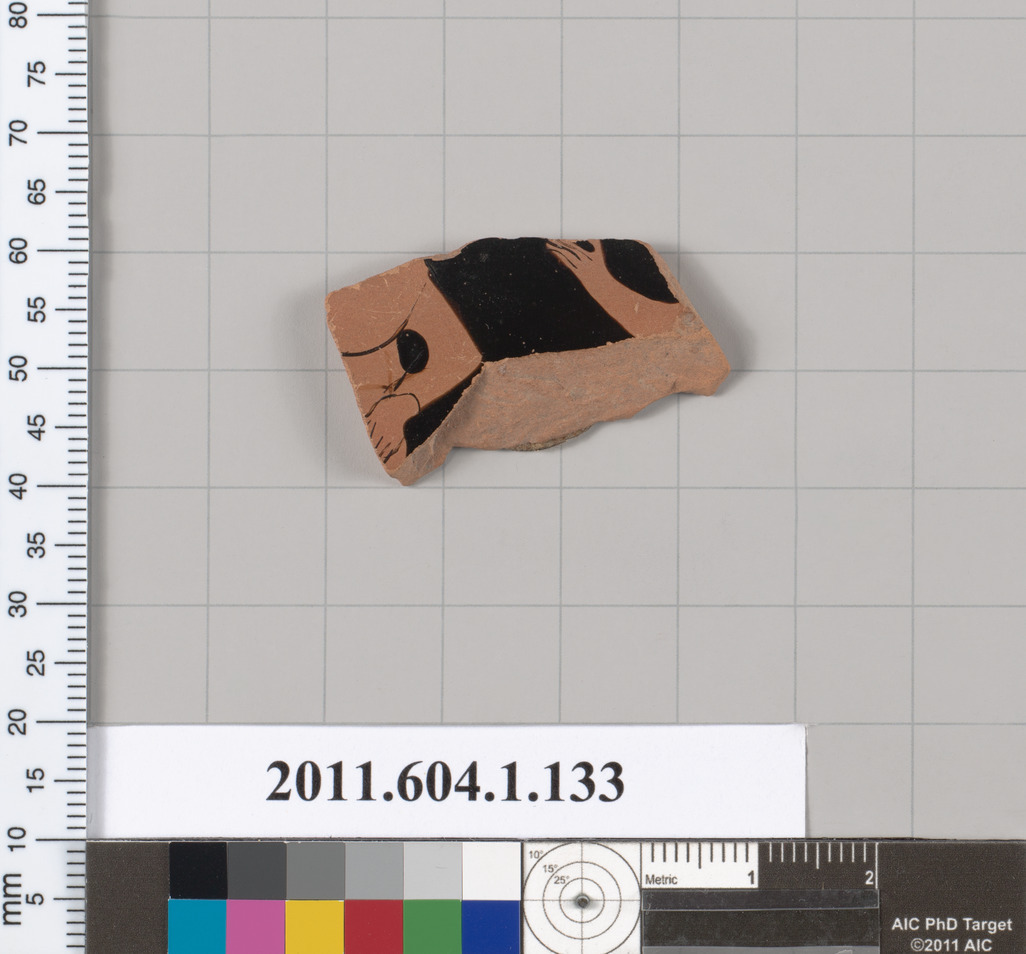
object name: kylix fragment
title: Terracotta fragment of a kylix (drinking cup)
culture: greek, attic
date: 475-451 BCE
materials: terracotta